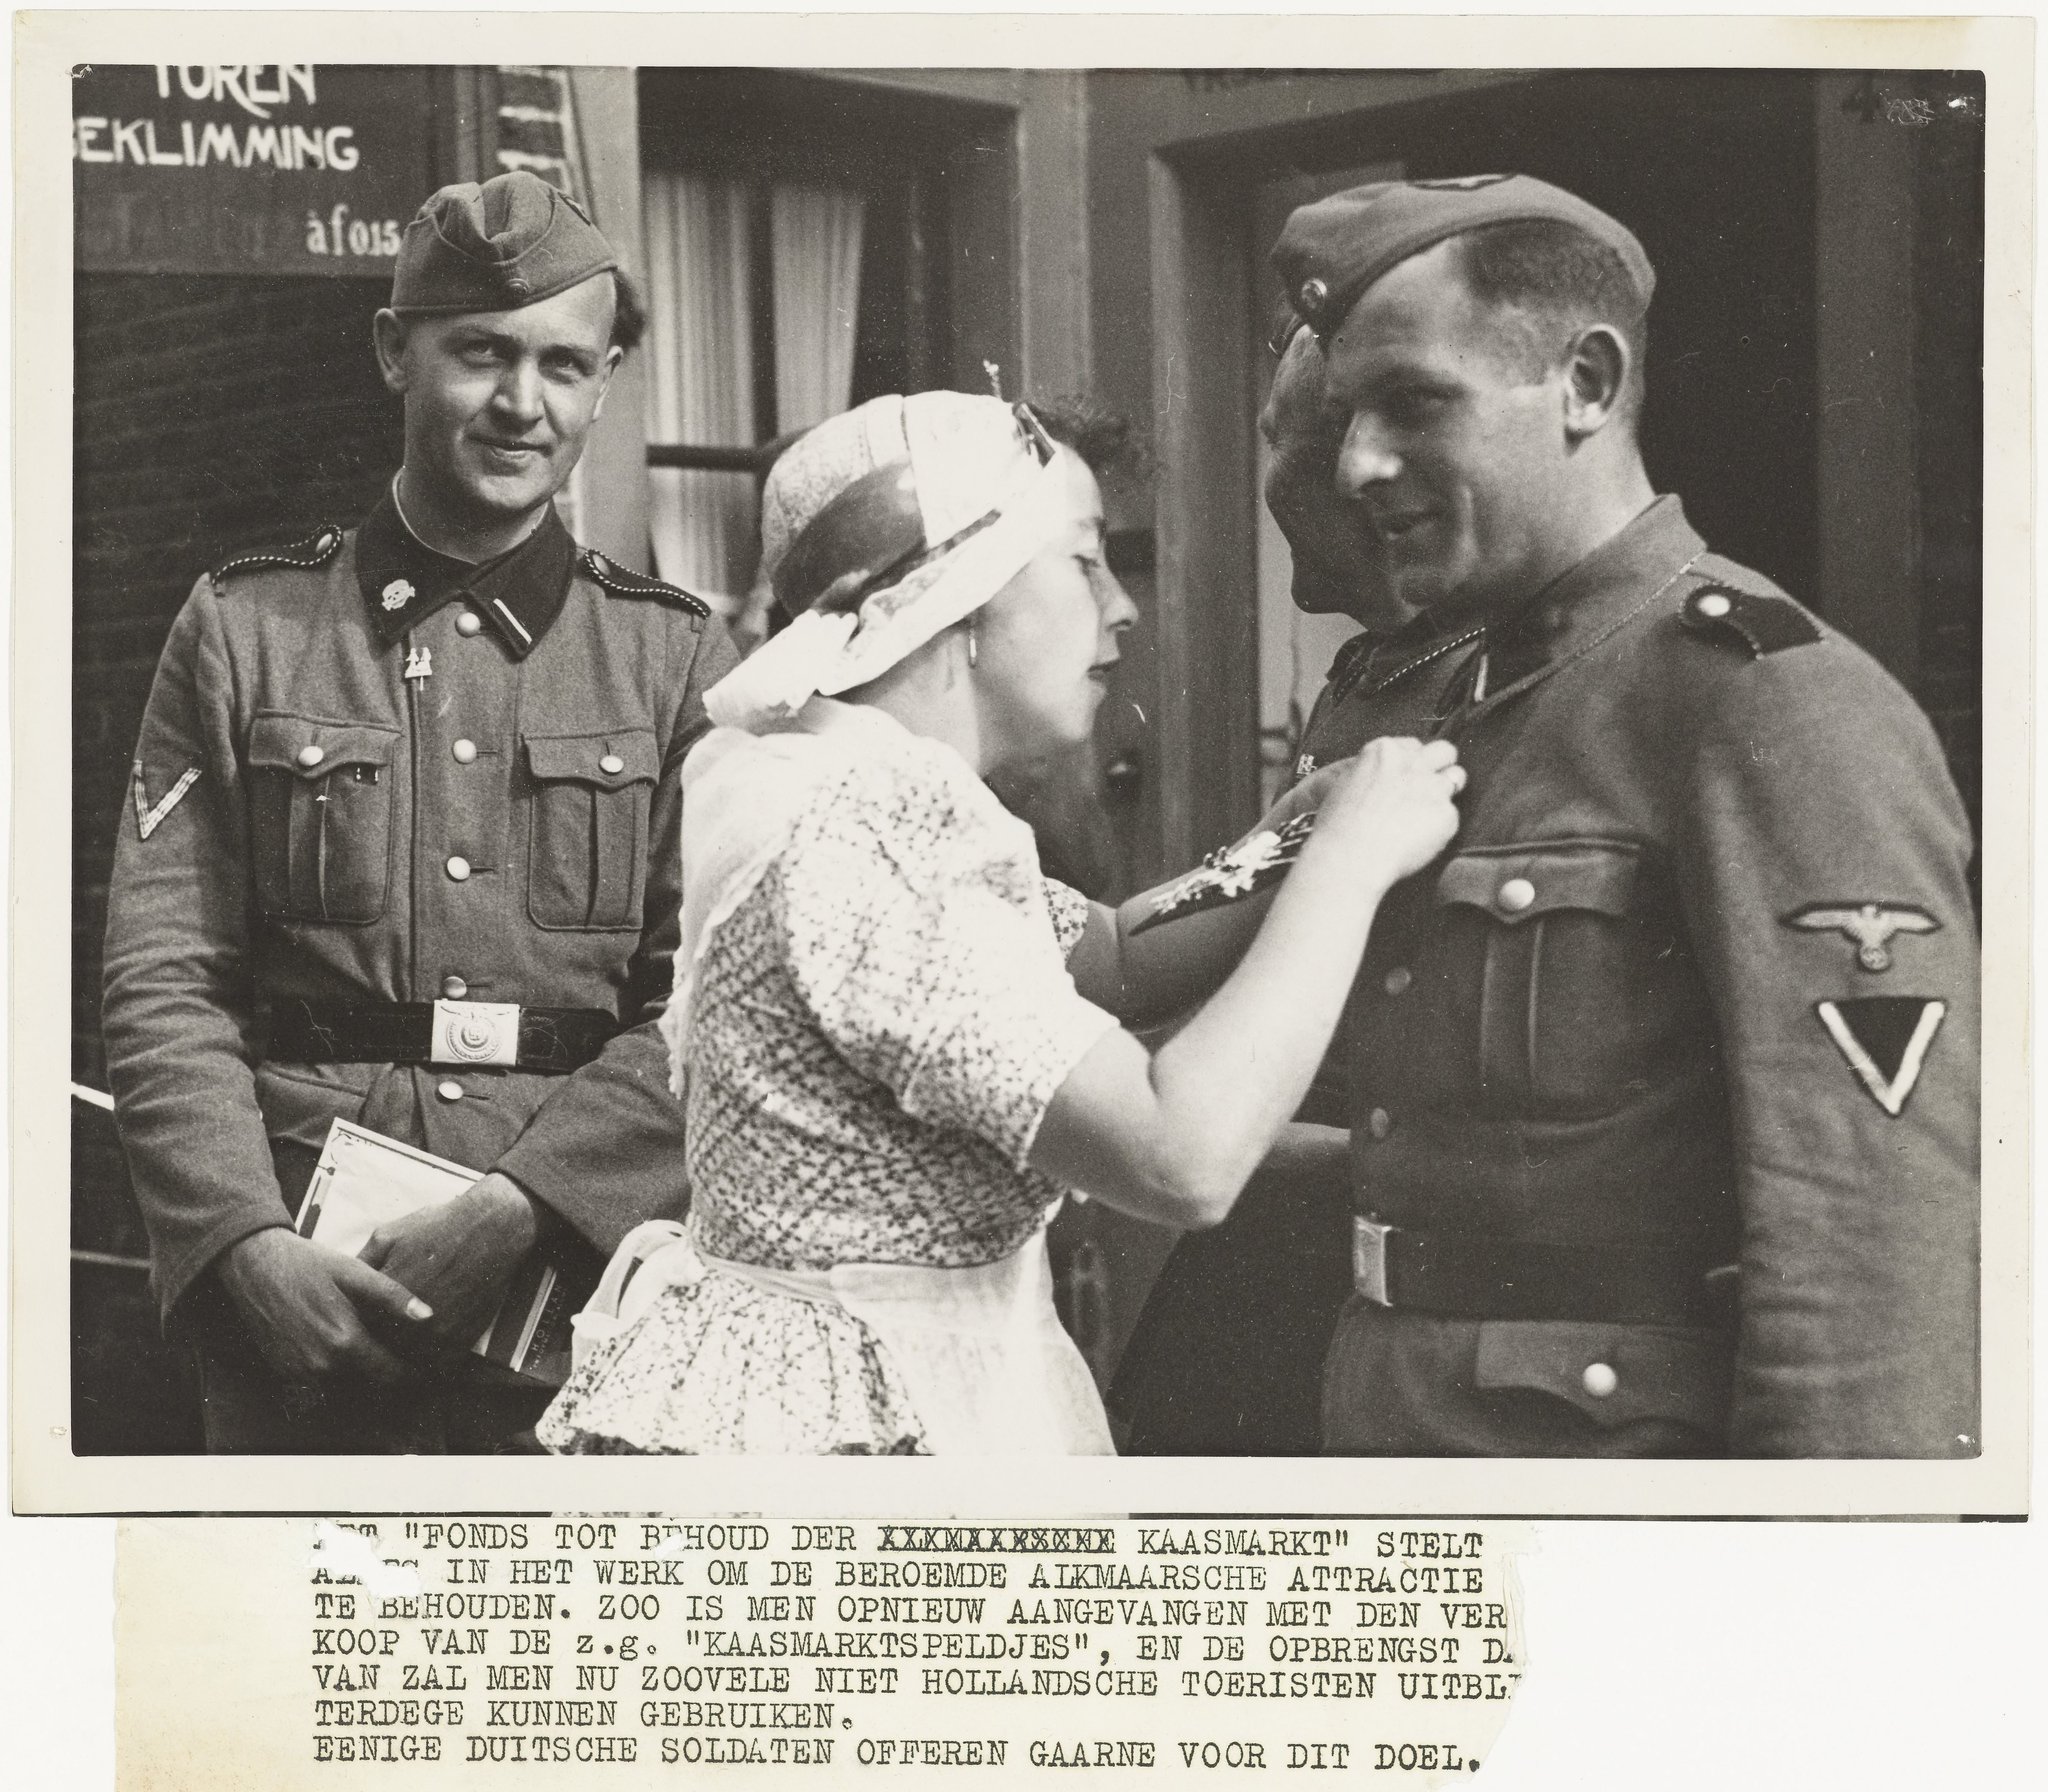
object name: photograph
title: Duitse soldaten op de Kaasmarkt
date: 1940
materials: photographic support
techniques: photography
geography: alkmaar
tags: occupier and civilians, soldiers and civilians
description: Duitse soldaten krijgen van een meisje in West-Friese dracht een Kaasmarktspeldje opgespeld. Tekststrookje aan foto geplakt.